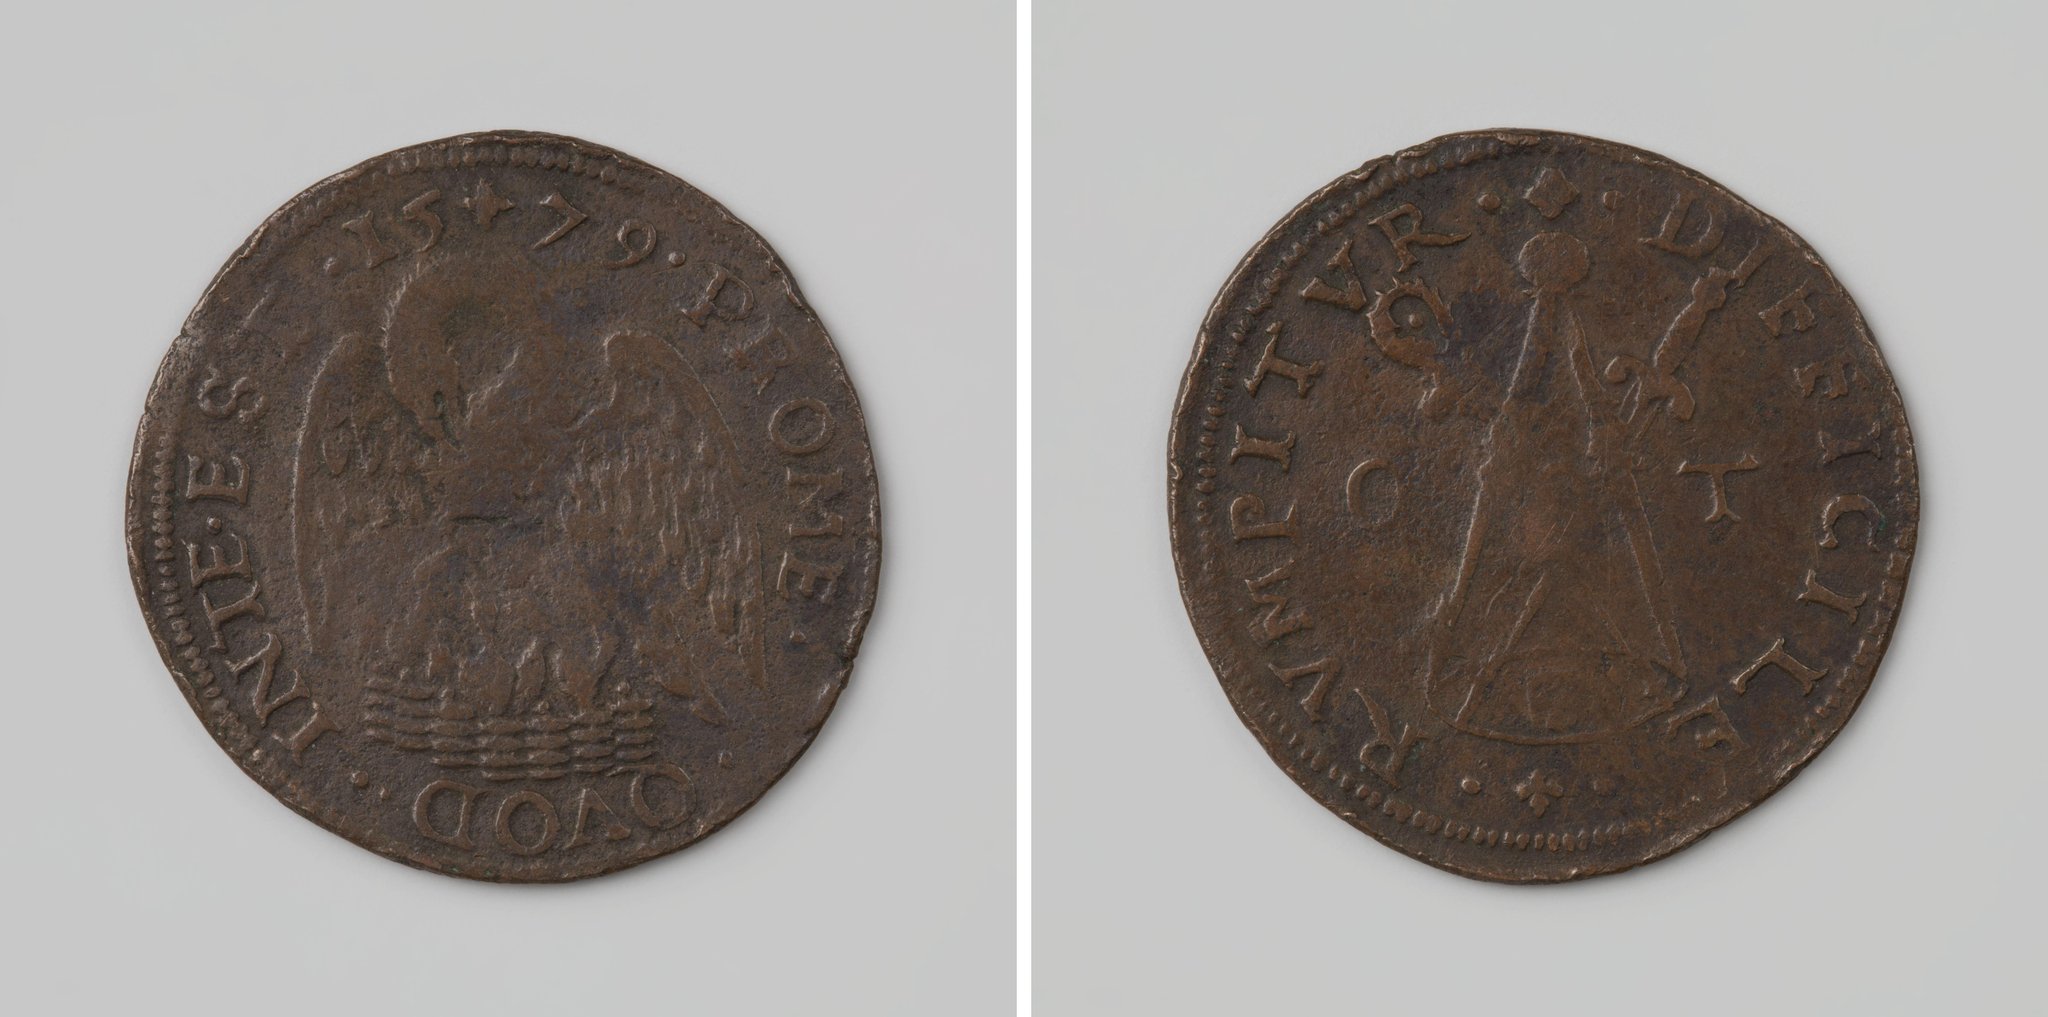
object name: jeton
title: Unie van Utrecht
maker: Anonymous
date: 1579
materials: copper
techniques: striking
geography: dordrecht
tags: utrecht, union of utrecht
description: Koperen penning. Voorzijde: pelikaan, die jongen met eigen bloed voedt binnen omschrift. Keerzijde: opengespreide passer, staande op cirkel, met keten en slot verbonden met gekruiste bisschopsstaf en zwaard, geflankeerd door de letters O en T binnen omschrift